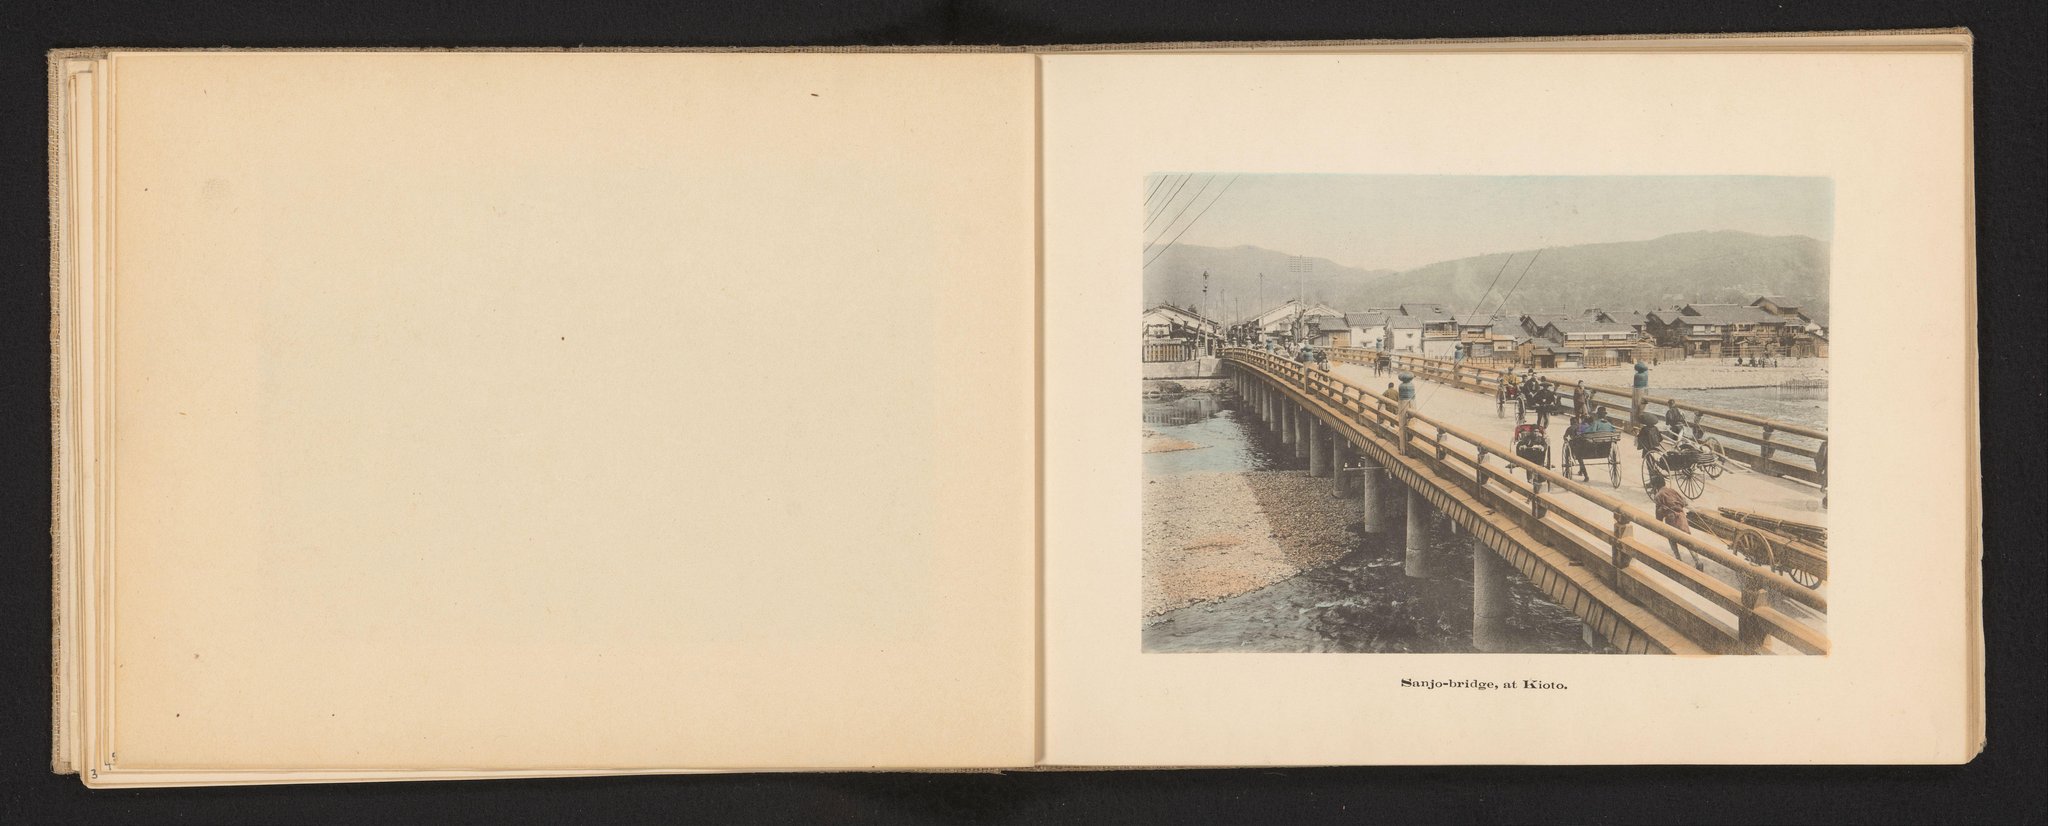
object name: photomechanical print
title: Sanjo-bridge, at Kioto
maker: kōzaburō tamamura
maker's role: fotograaf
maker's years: 1856-1923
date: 1895-1905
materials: paper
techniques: photograph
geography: kyoto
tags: hand-cart, bridge in city across river, canal, etc.